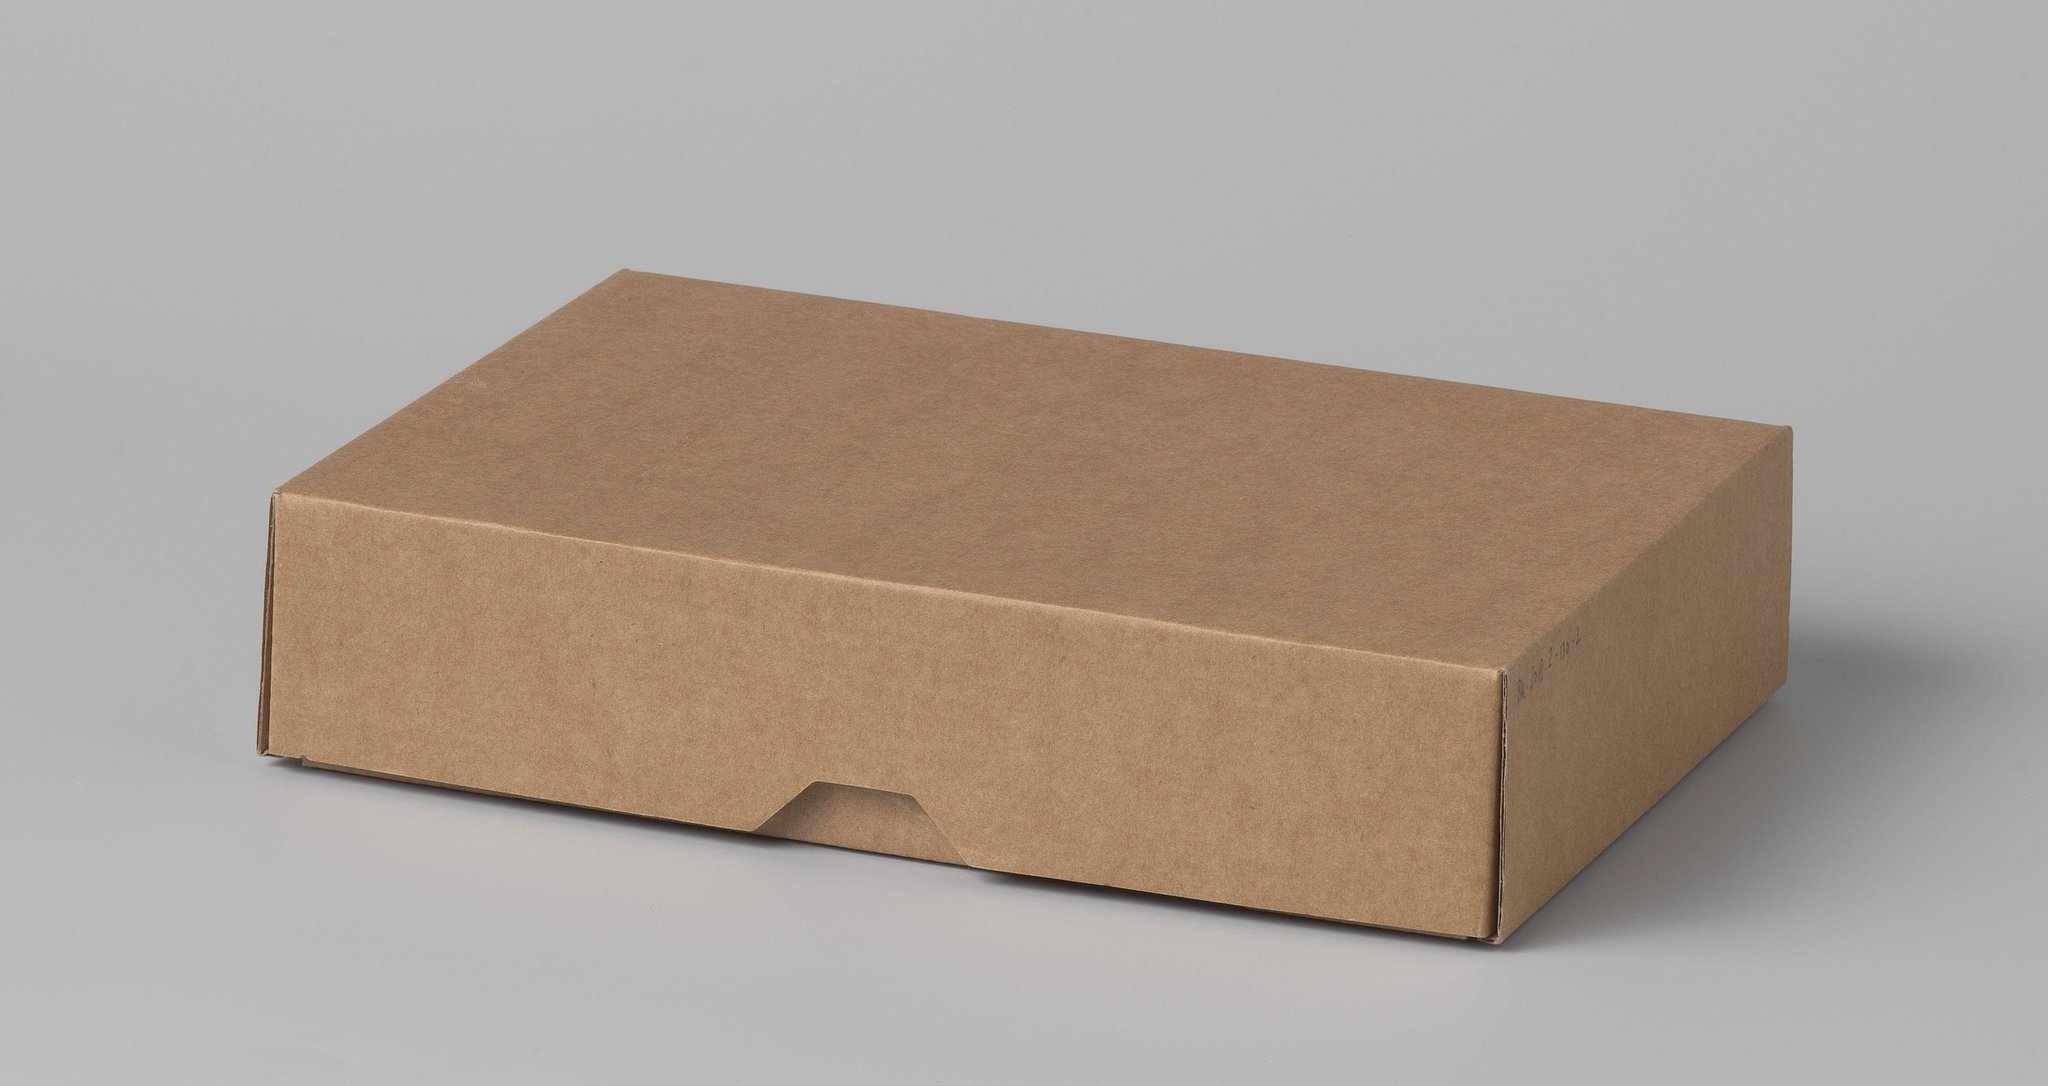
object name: brooch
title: Doos voor Everybody needs a rock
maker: sae honda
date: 2016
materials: cardboard, paper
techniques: printed materials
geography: amsterdam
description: Rechthoekige doos met los deksel van bruin karton met daarin een vel zwart karton met tekst en een zwart vel papier met tekst. De teksten gaan over de materialen waaruit de broche is opgebouwd.